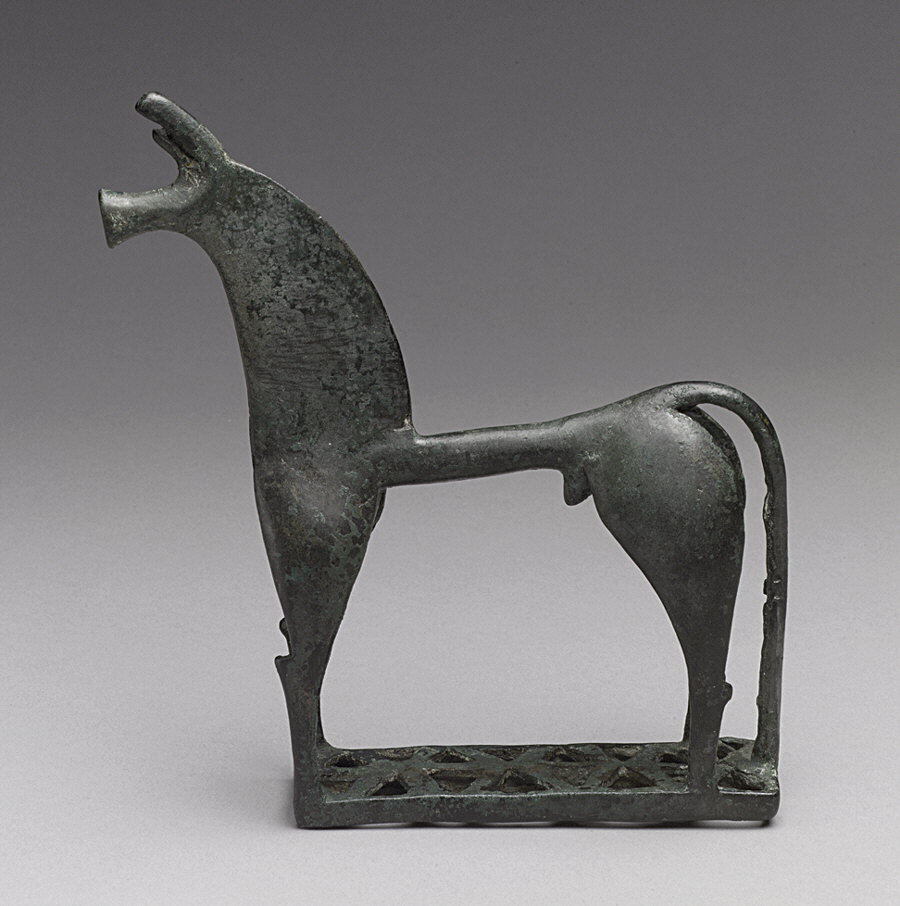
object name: statuette of a horse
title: Bronze horse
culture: greek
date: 800-701 BCE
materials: bronze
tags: horses